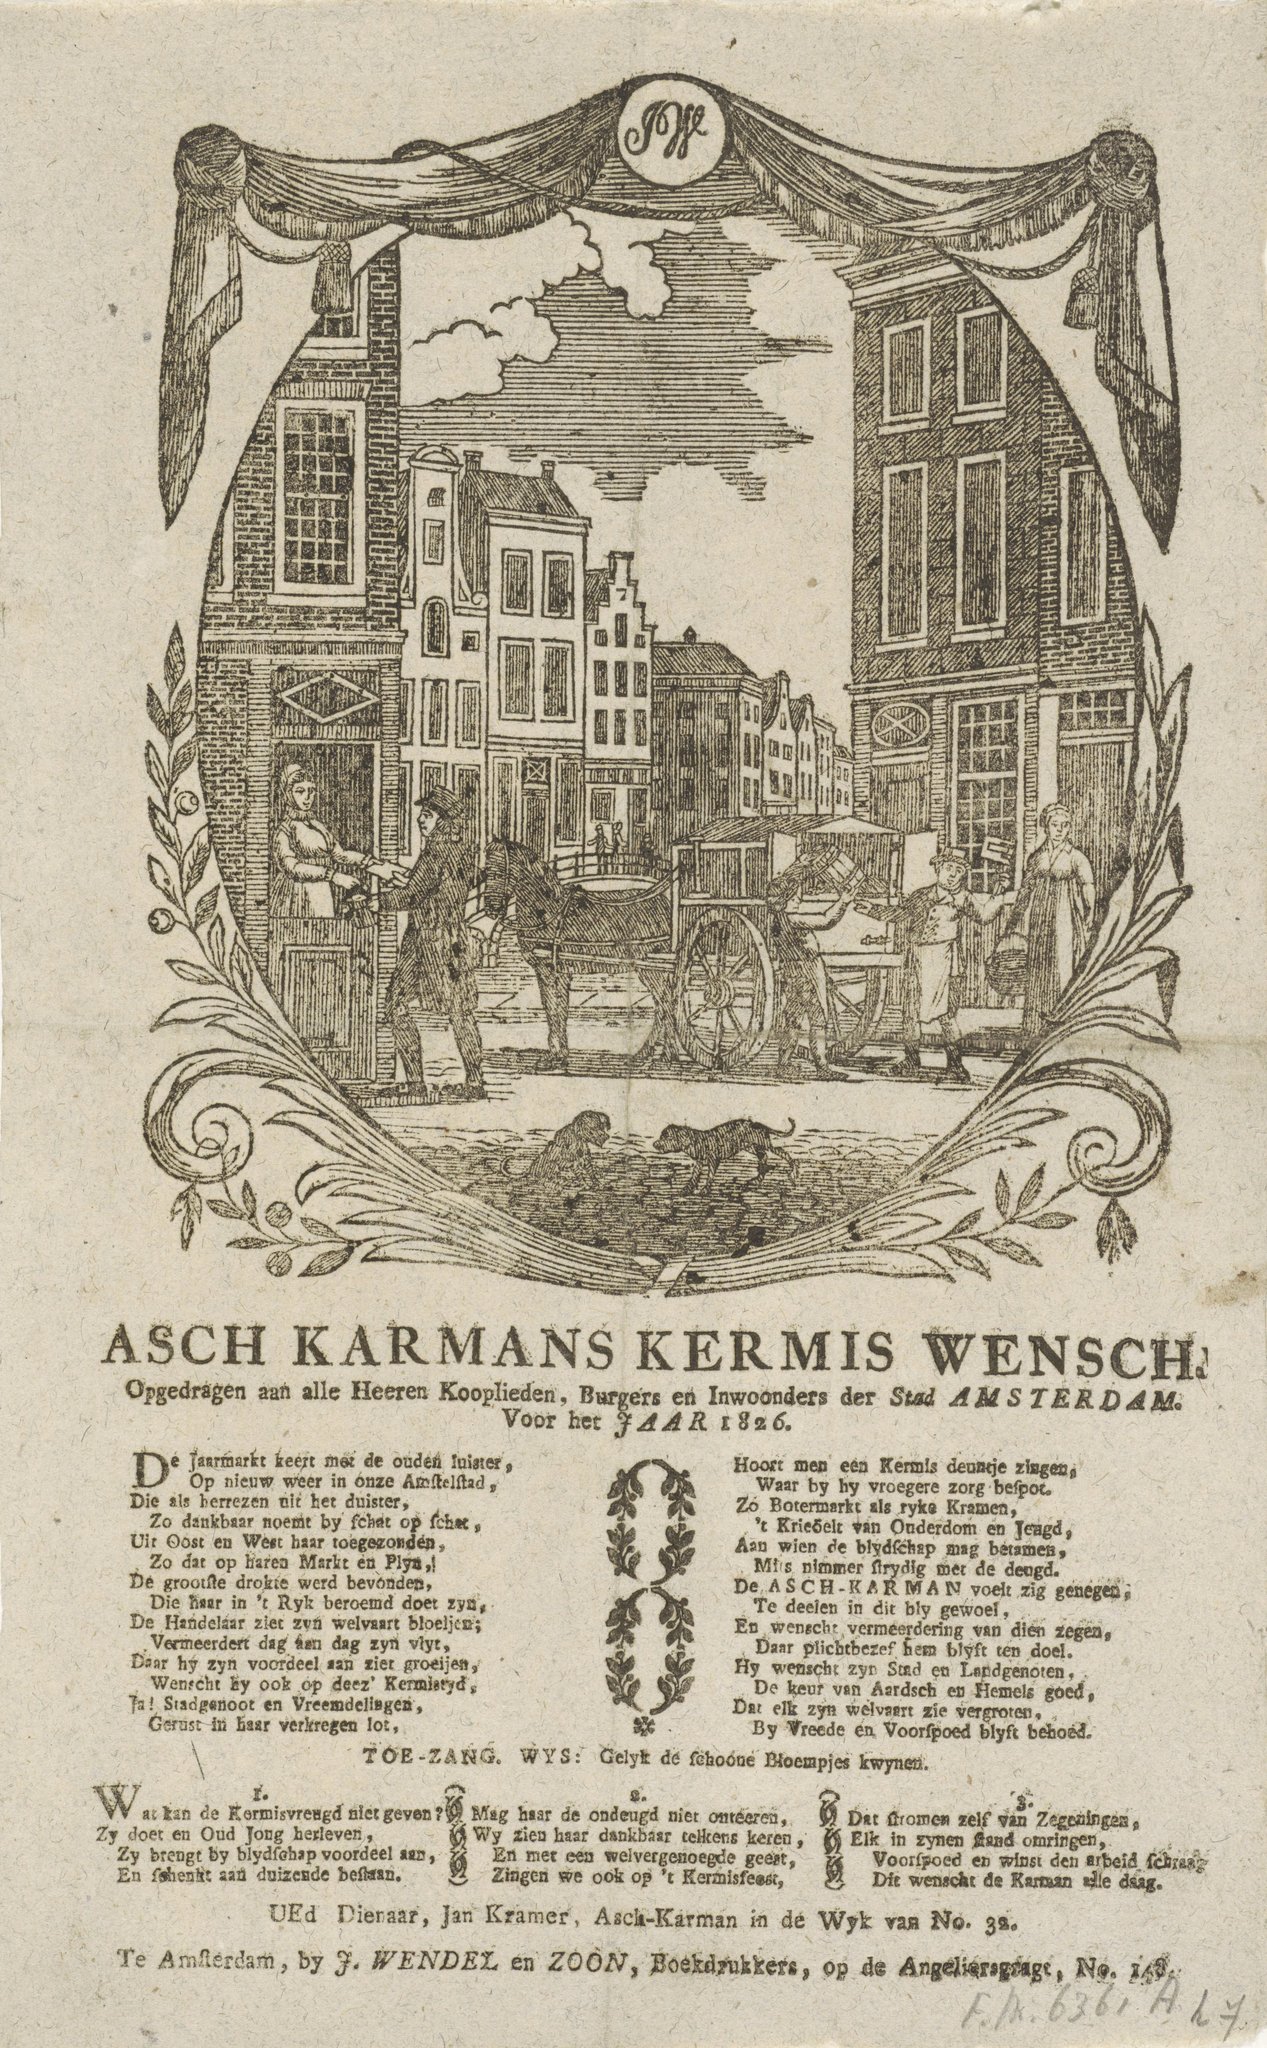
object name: fair print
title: Asch Karmans Kermis Wensch (...) 1826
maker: Anonymous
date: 1826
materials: paper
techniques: letterpress printing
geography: amsterdam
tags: public road - ii - ideal city, garbage collection, amsterdam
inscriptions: collector's mark: Lugt 2228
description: Kermisprent namens de askarrenmannen (karrenman of vuilnisman) te Amsterdam voor het jaar 1826. Gezicht in een straat te Amsterdam met een jongen die een asemmer in een kar leeg gooit, een jongen met een ratel en een man die aan huis geld ophaalt. Onderaan een gedicht in twee kolommen en een lied in drie verzen. Namens Jan Kramer, de askarreman van wijk no. 32.